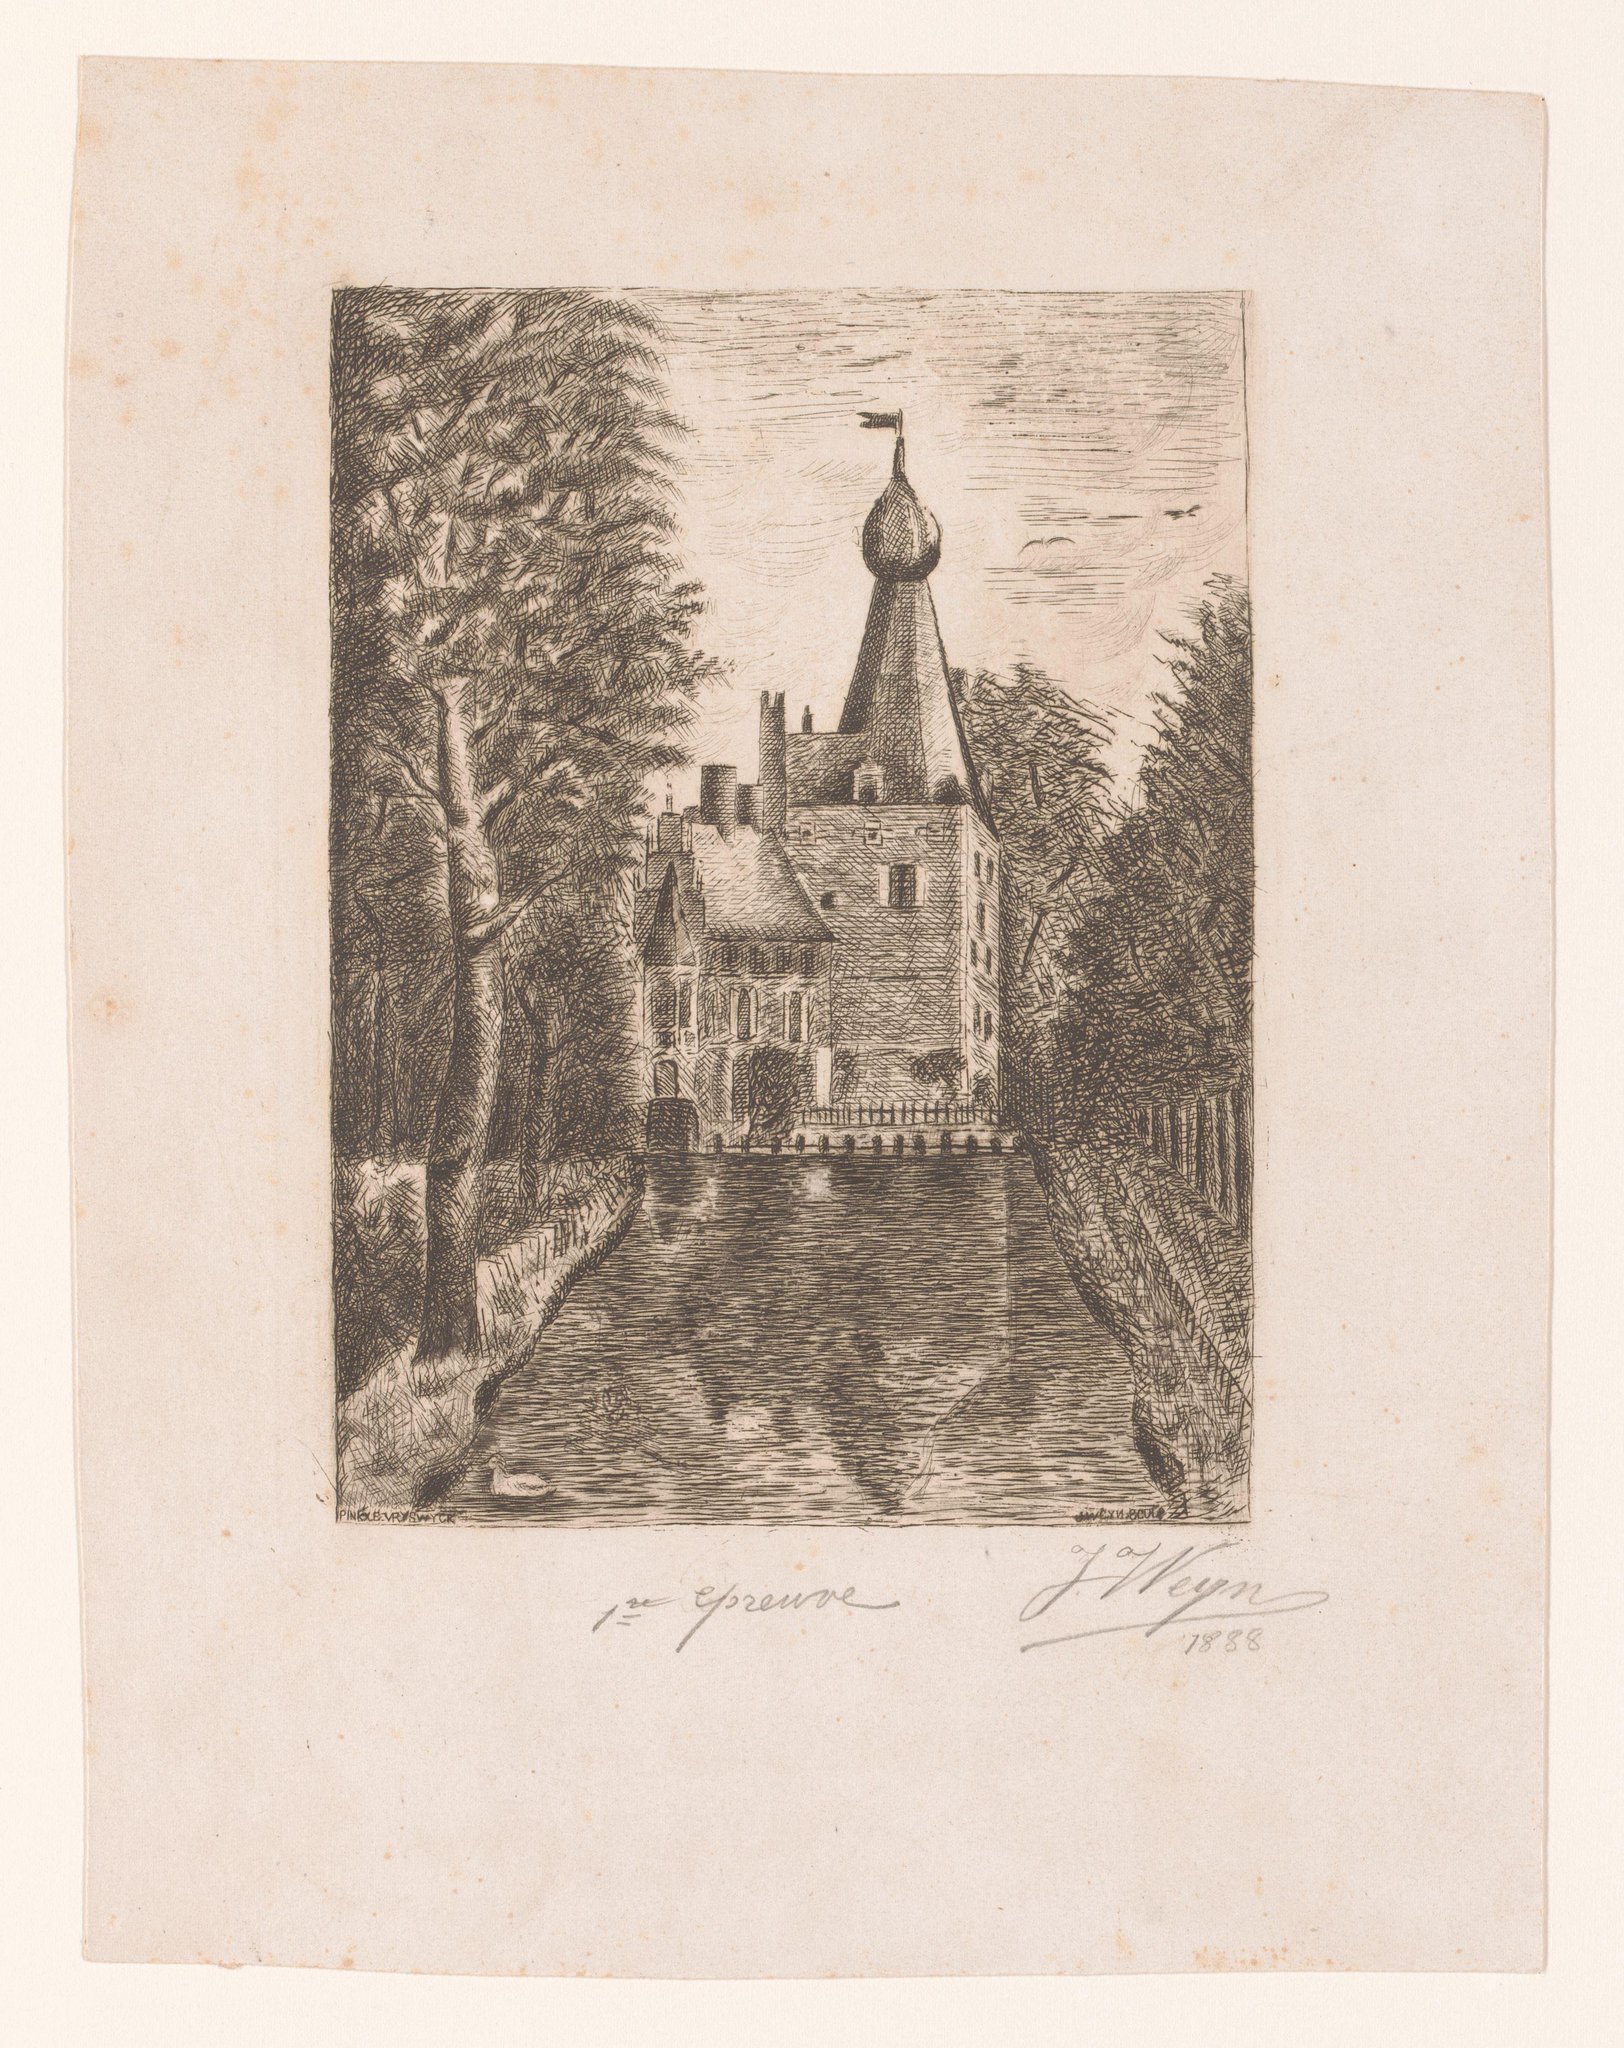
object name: print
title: Kasteel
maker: j. weyn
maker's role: print maker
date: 1888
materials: paper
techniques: drypoint, etching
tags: castle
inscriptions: collector's mark: Lugt 2228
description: Sterfdatum van de prentmaker is onbekend. Daarom is voor de bepaling van de rechten van dit object gebruik gemaakt van de verwervingsdatum Rijksmuseum Amsterdam.